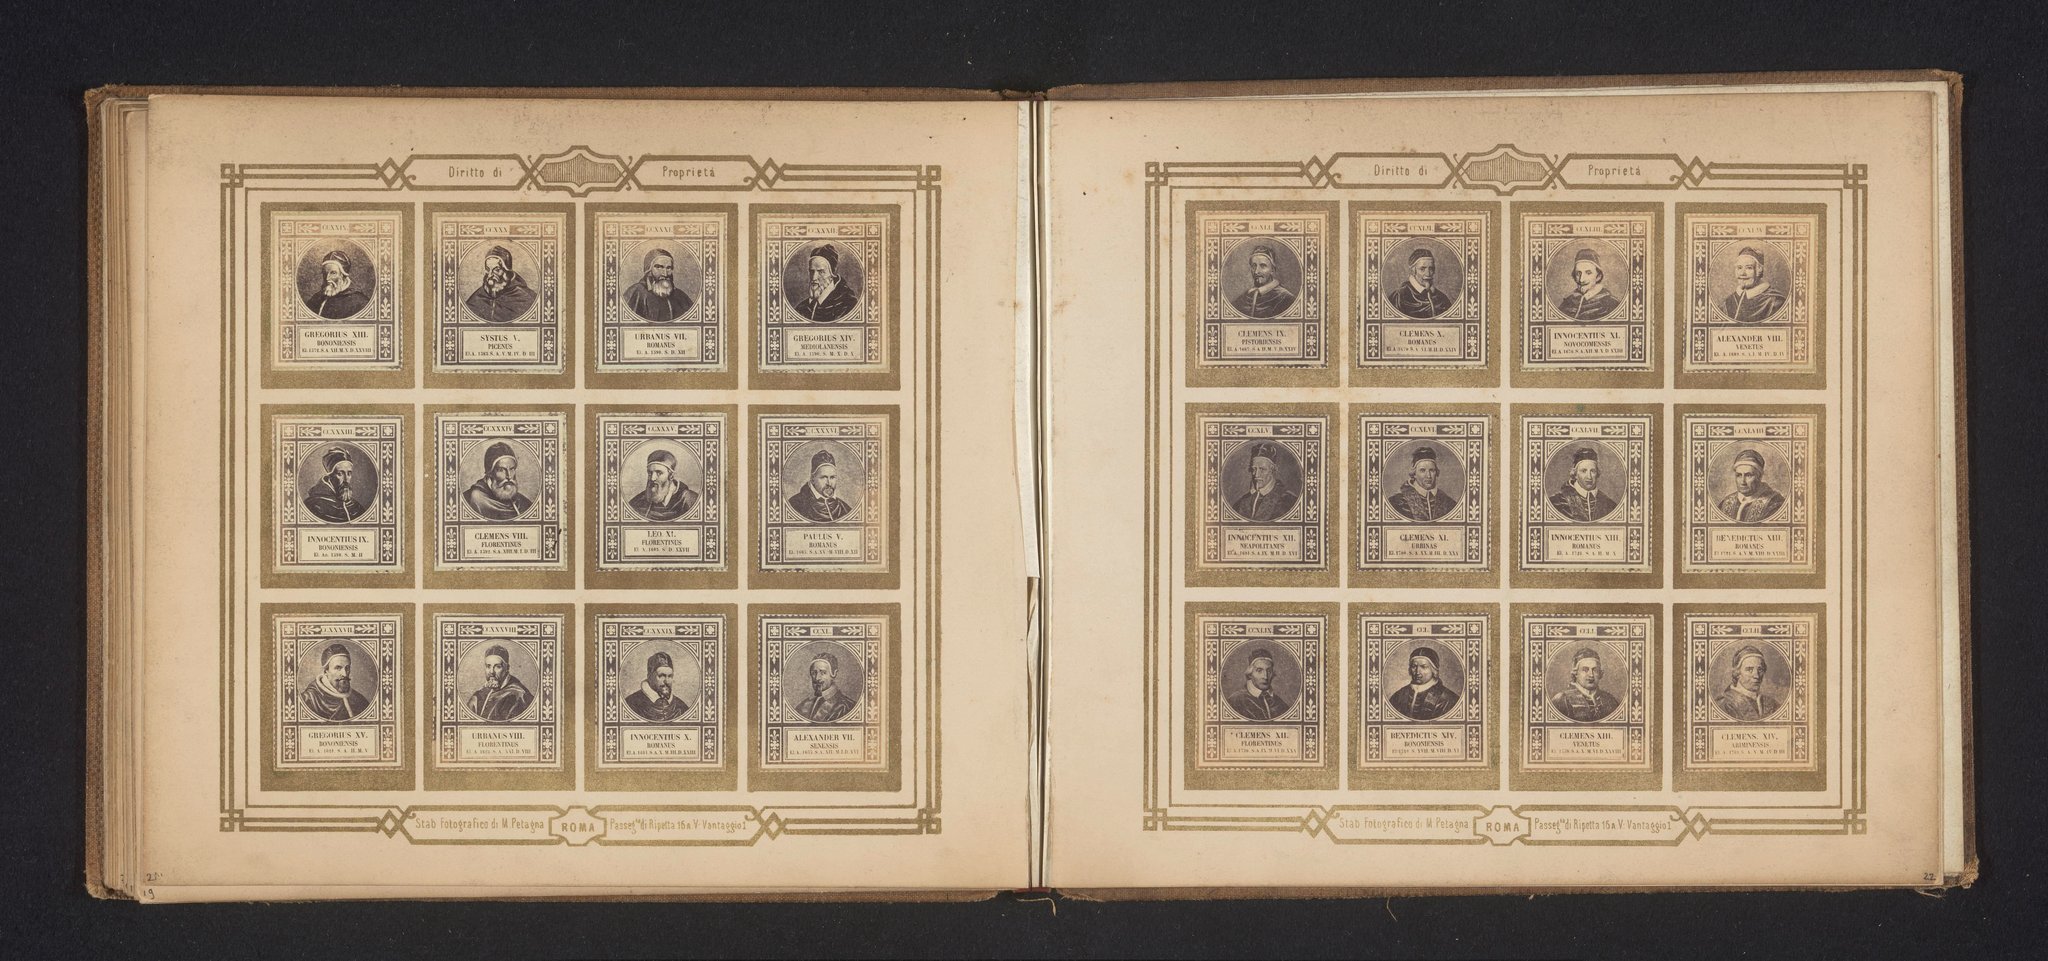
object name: reproduction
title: Fotoreproductie van twaalf portretten van pausen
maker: m. petagna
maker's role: fotograaf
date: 1854-1864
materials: photographic support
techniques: albumen print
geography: rome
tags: pope